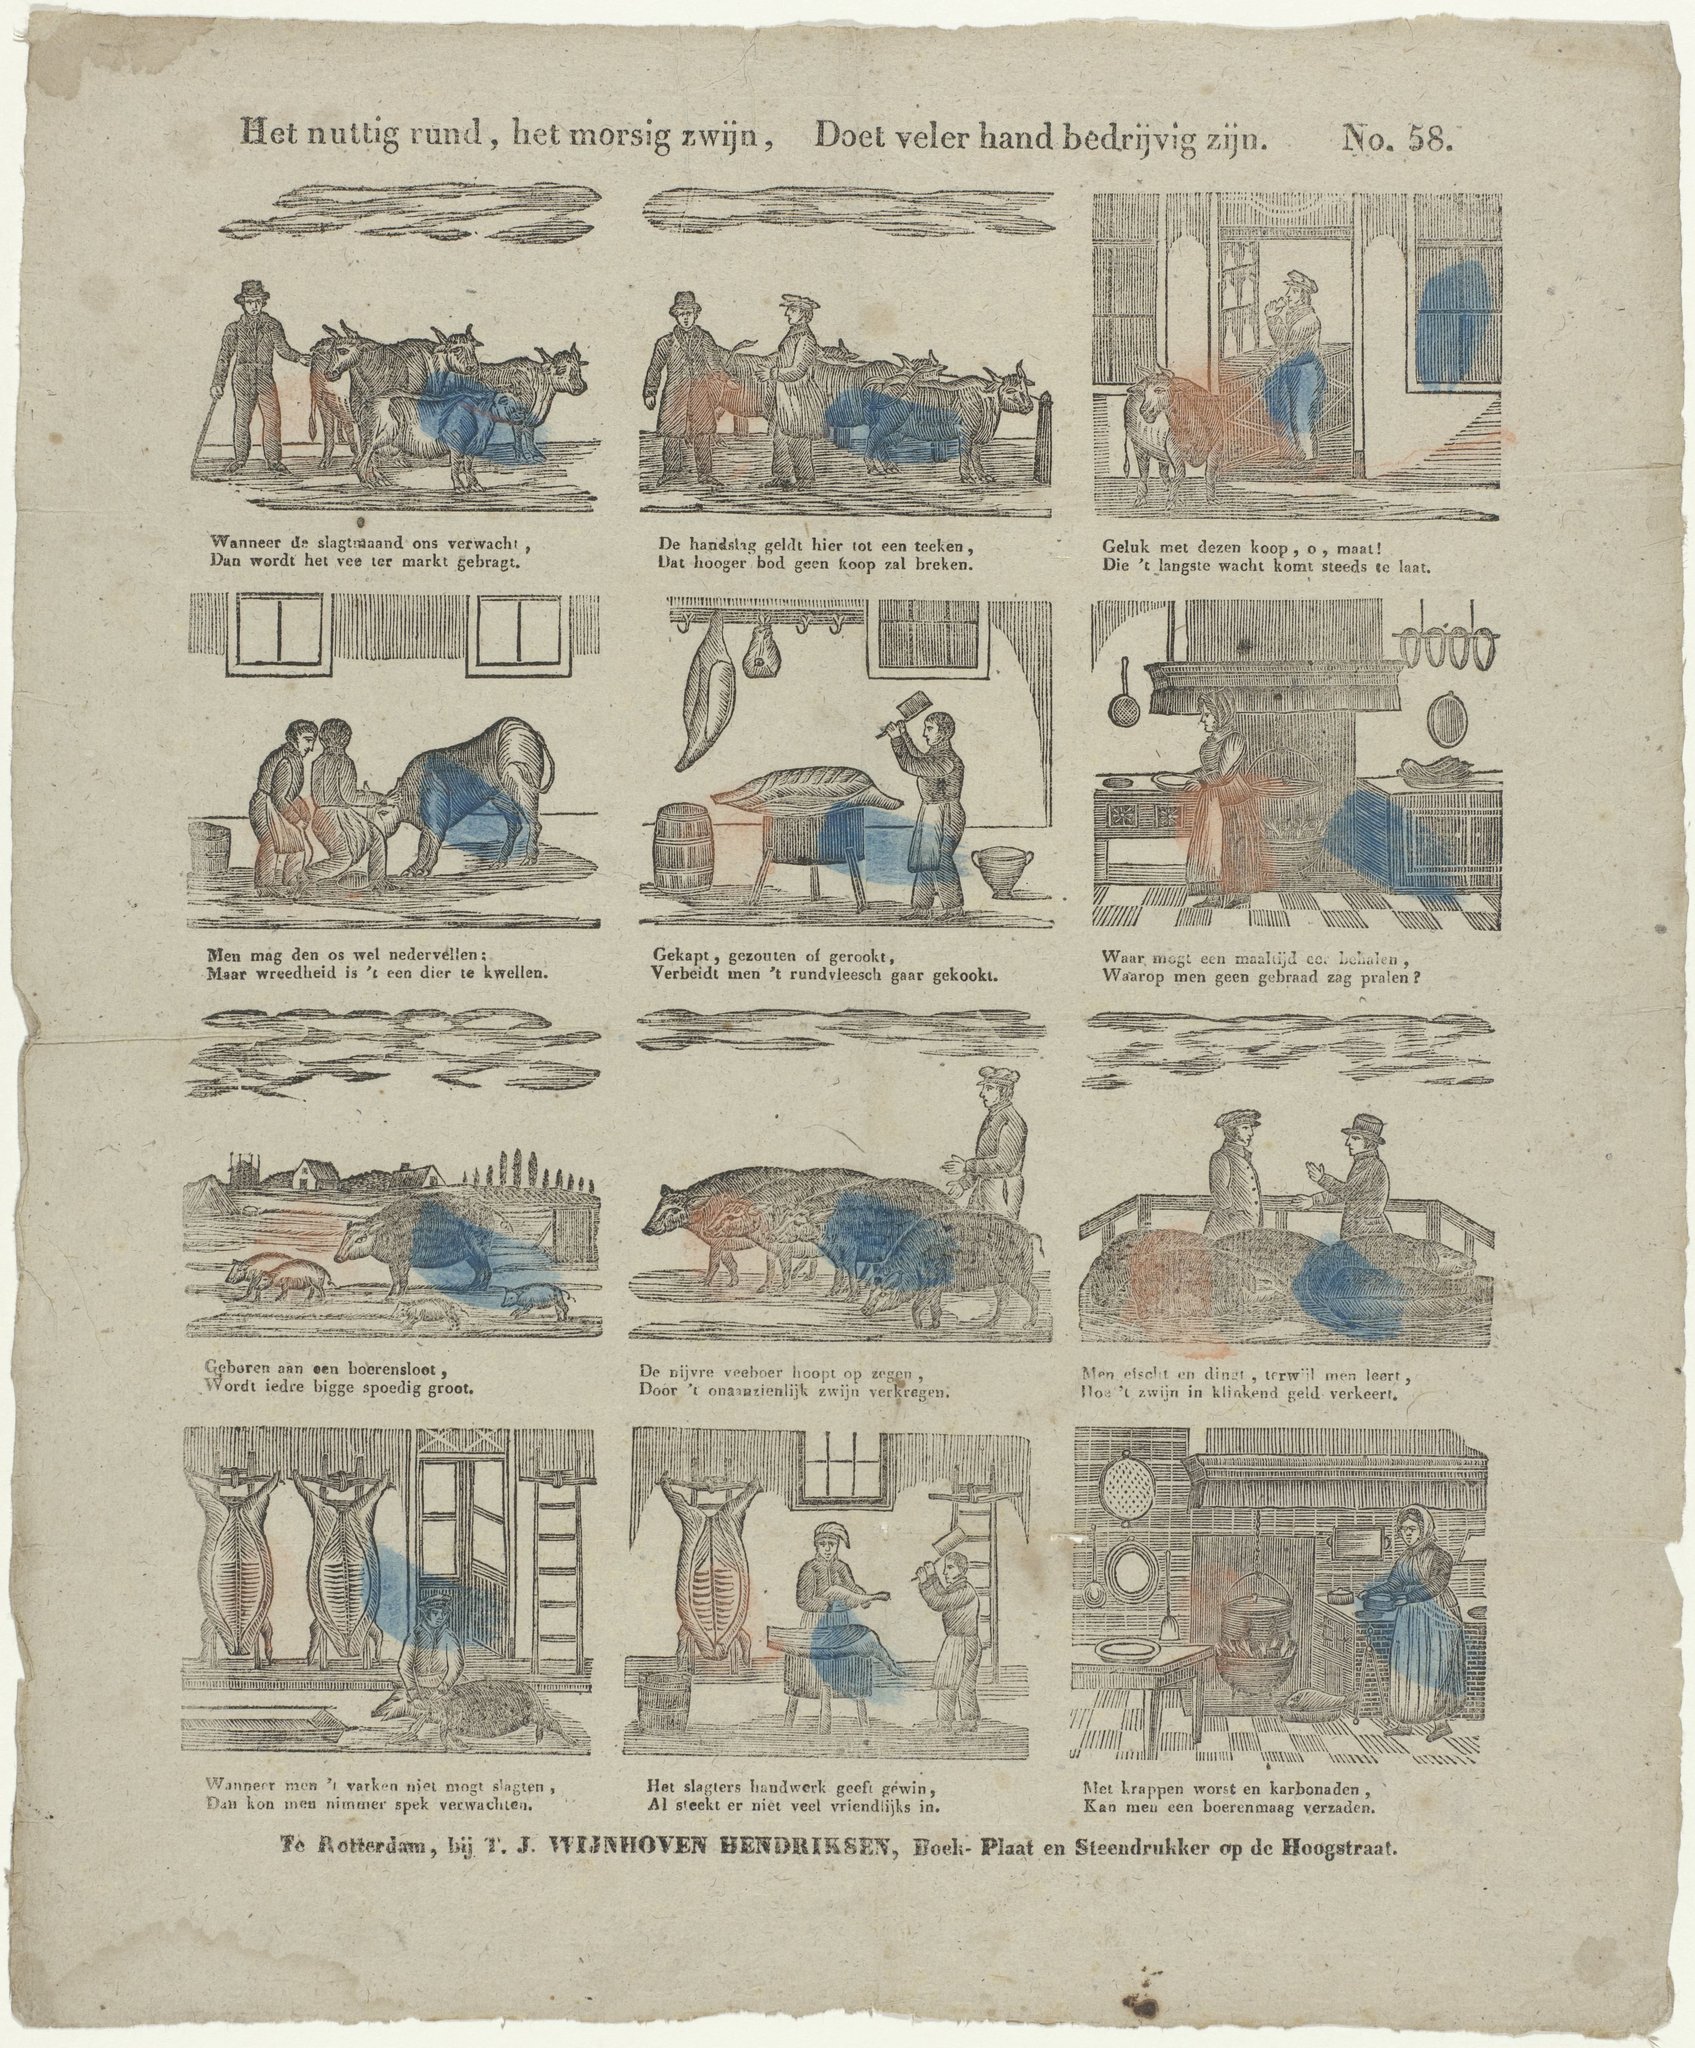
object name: print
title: Het nuttig rund, het morsig zwijn, Doet veler hand bedrijvig zijn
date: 1832-1850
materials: paper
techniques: colour, letterpress printing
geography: rotterdam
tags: slaughtered ox or pig, butcher, slaughterman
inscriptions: collector's mark: Lugt 2228, collector's mark: Lugt 2760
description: Blad met 12 voorstellingen van het fokken, slachten en bereiden van koeien en varkens. Onder elke afbeelding een tweeregelig vers. Genummerd rechtsboven: No. 58.